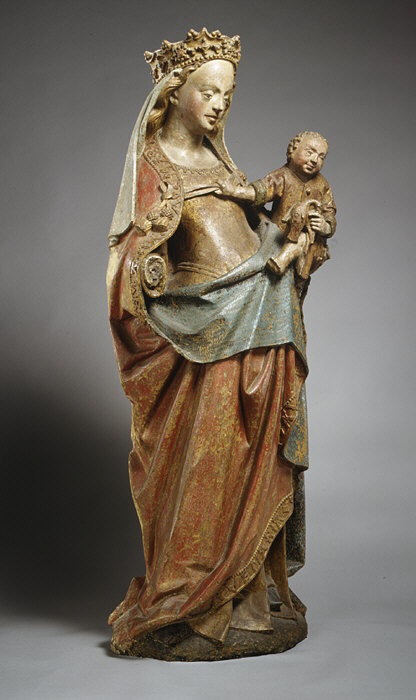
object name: statue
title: Virgin and Child with Bird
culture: french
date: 1434-1466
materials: limestone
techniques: polychromy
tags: birds